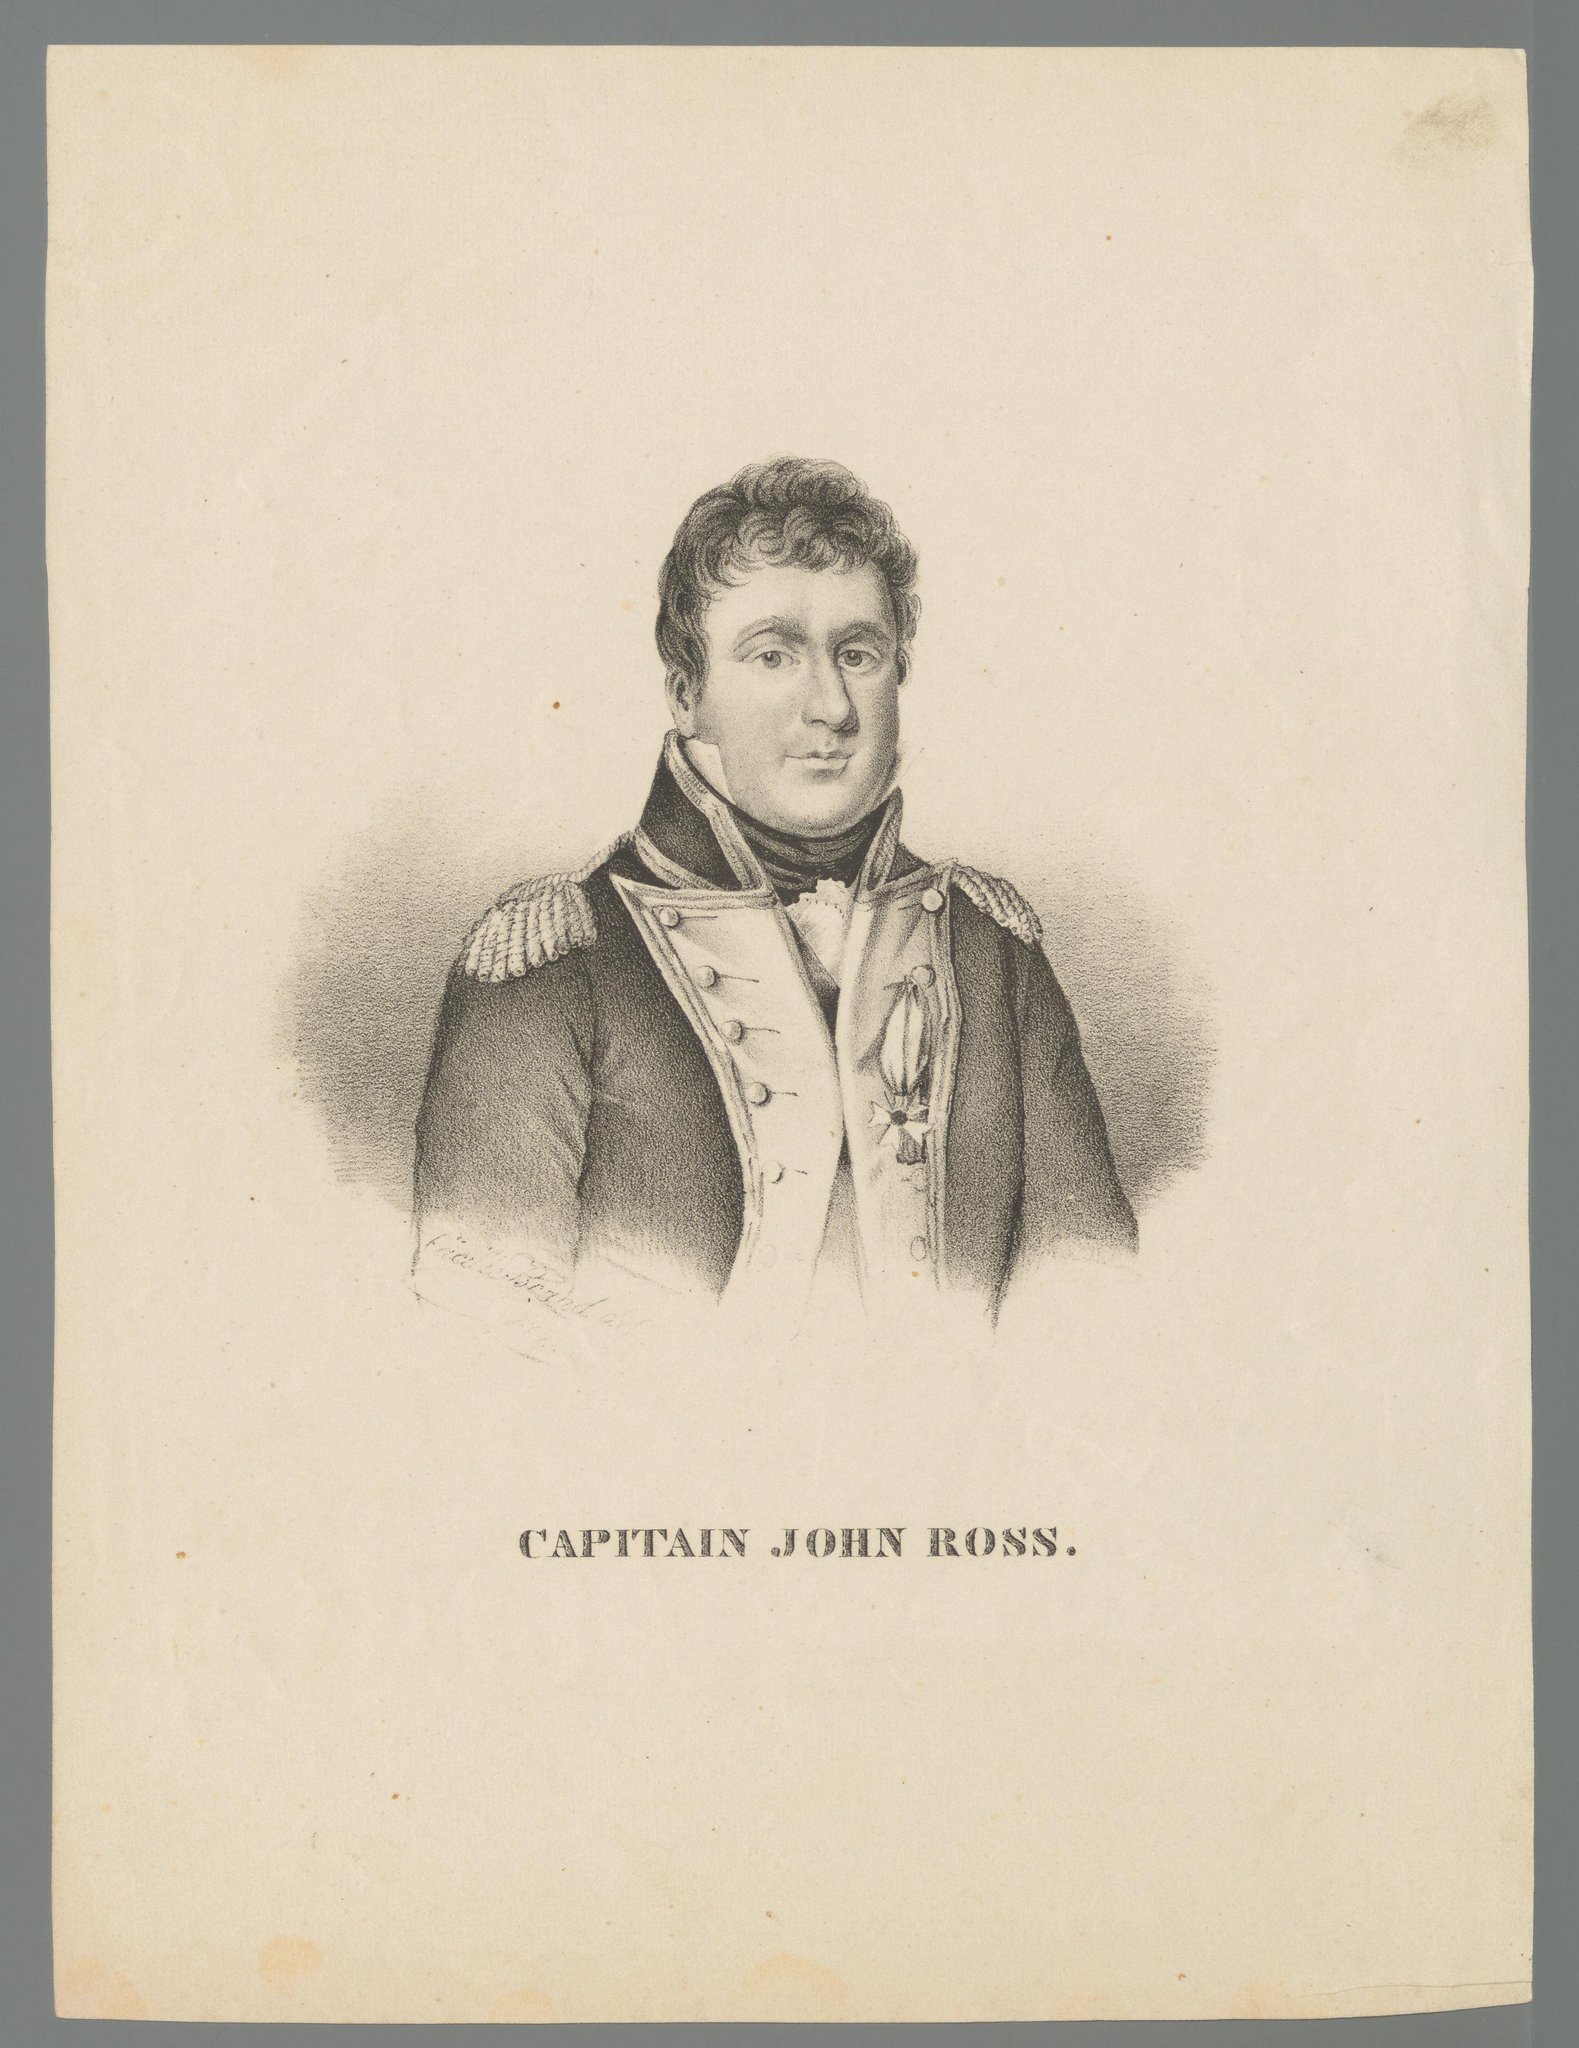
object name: print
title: Portret van John Ross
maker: cäcilie brandt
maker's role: print maker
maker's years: 1814-1852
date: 1825-1850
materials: paper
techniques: lithograph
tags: draughtsman, publisher, john ross, adult man, historical persons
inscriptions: collector's mark: Lugt 2228